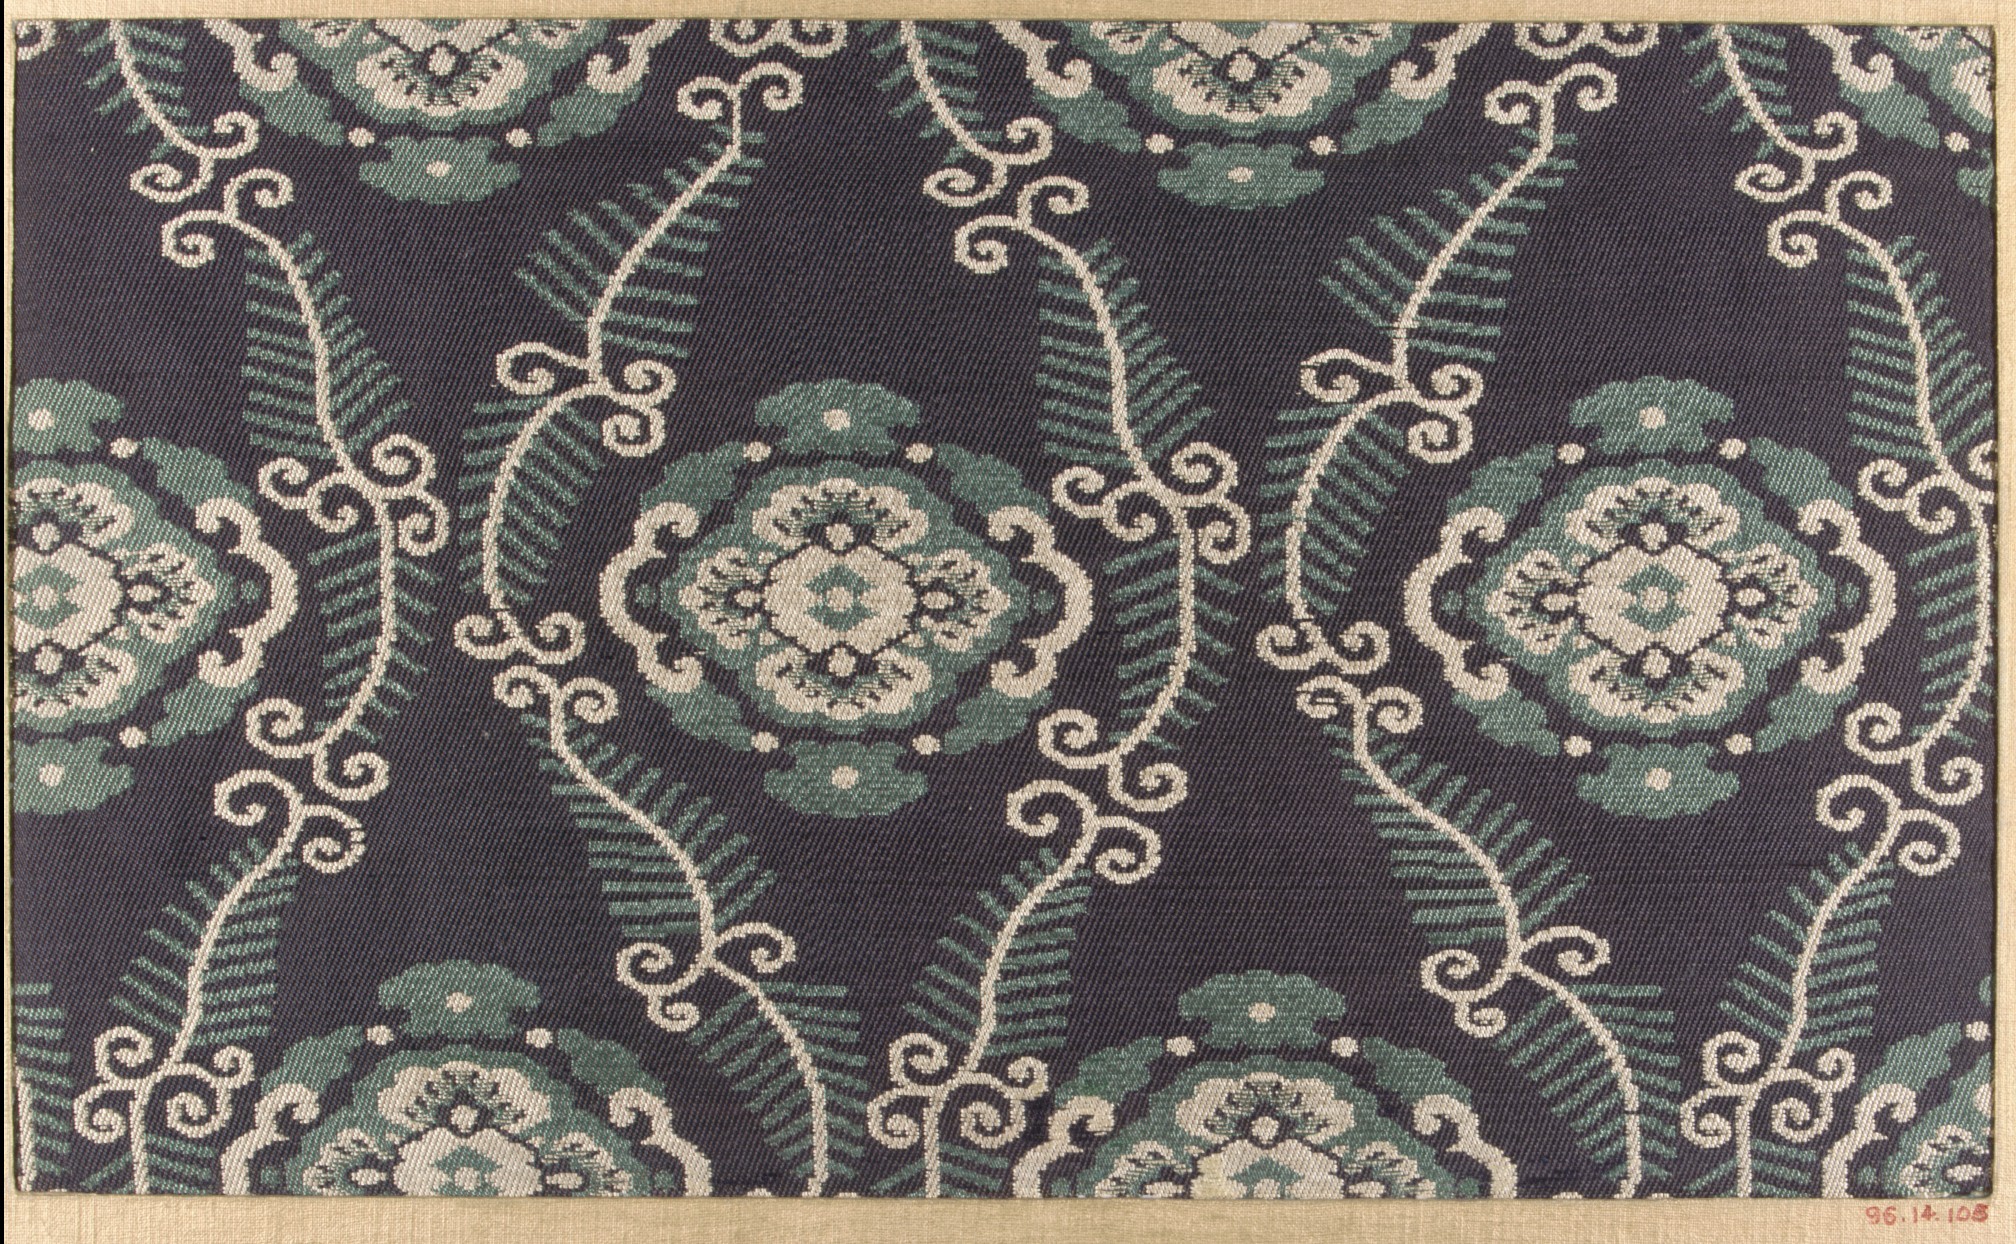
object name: piece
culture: japanese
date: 1701-1900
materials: silk